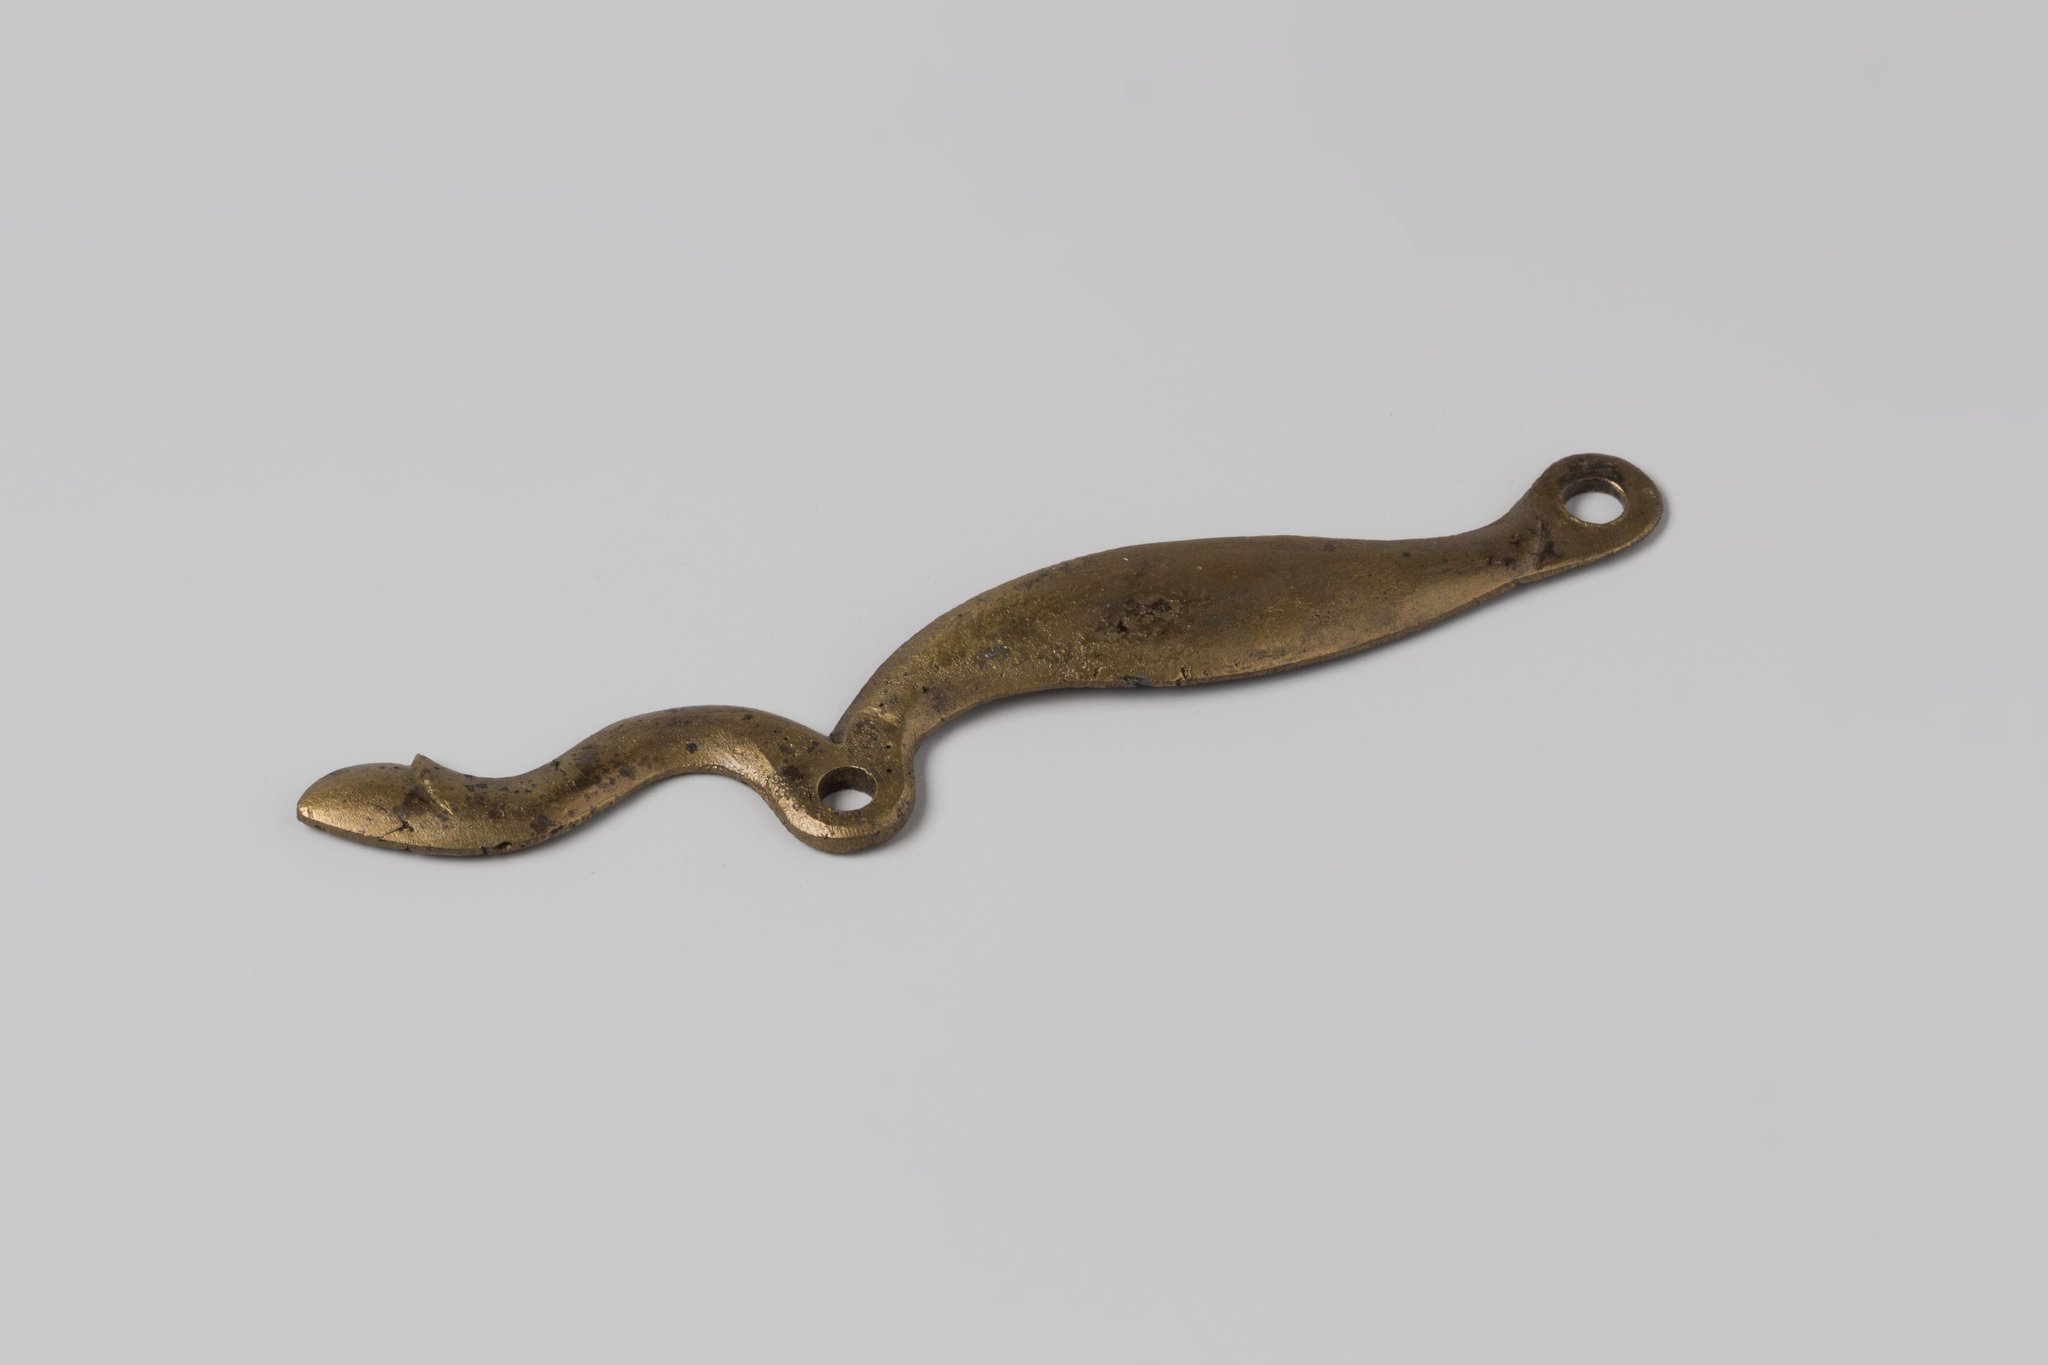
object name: pistol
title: Zijplaat van een pistool uit het wrak van de Oost-Indiëvaarder Hollandia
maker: Anonymous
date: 1700-1743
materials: copper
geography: netherlands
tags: verenigde oostindische compagnie, hollandia (schip), annet